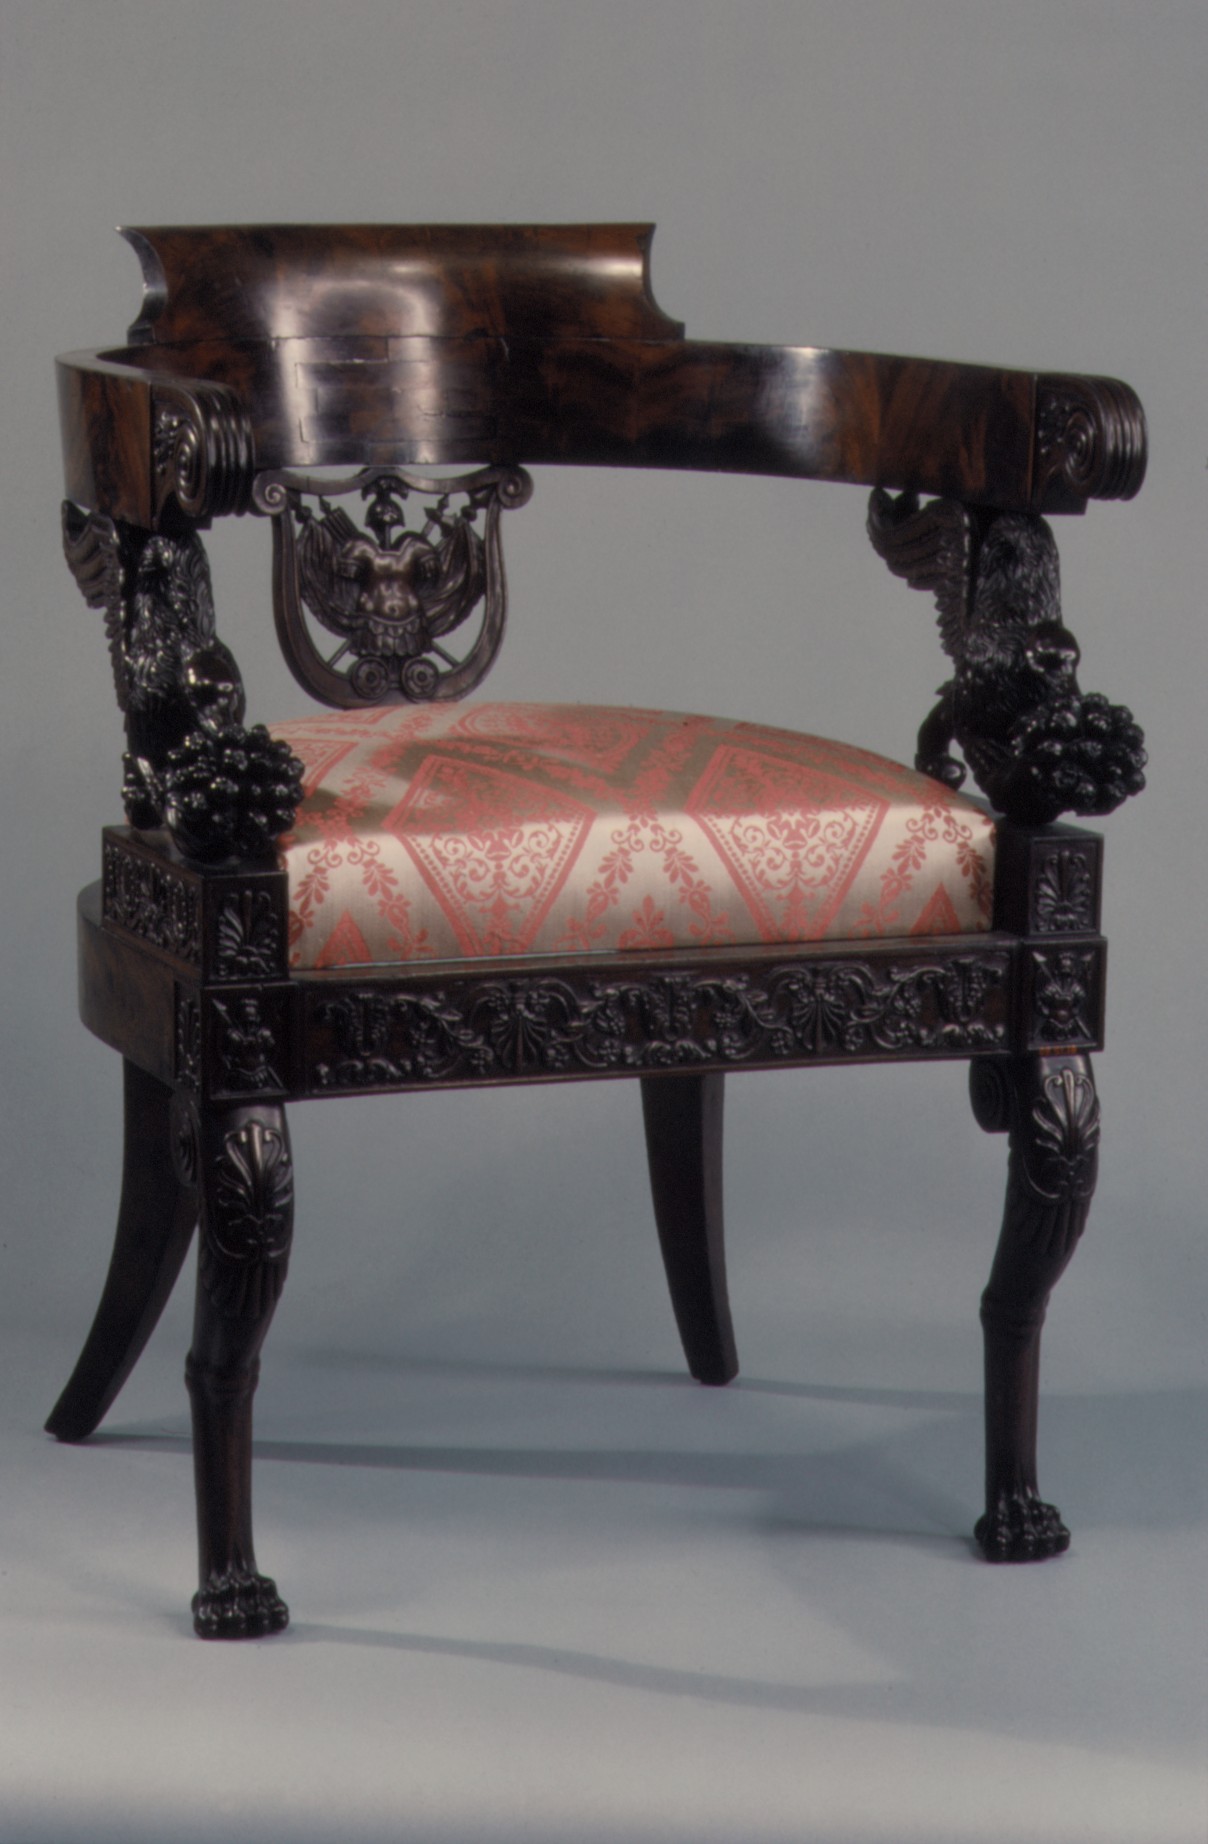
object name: armchair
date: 1830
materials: wood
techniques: veneering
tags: birds